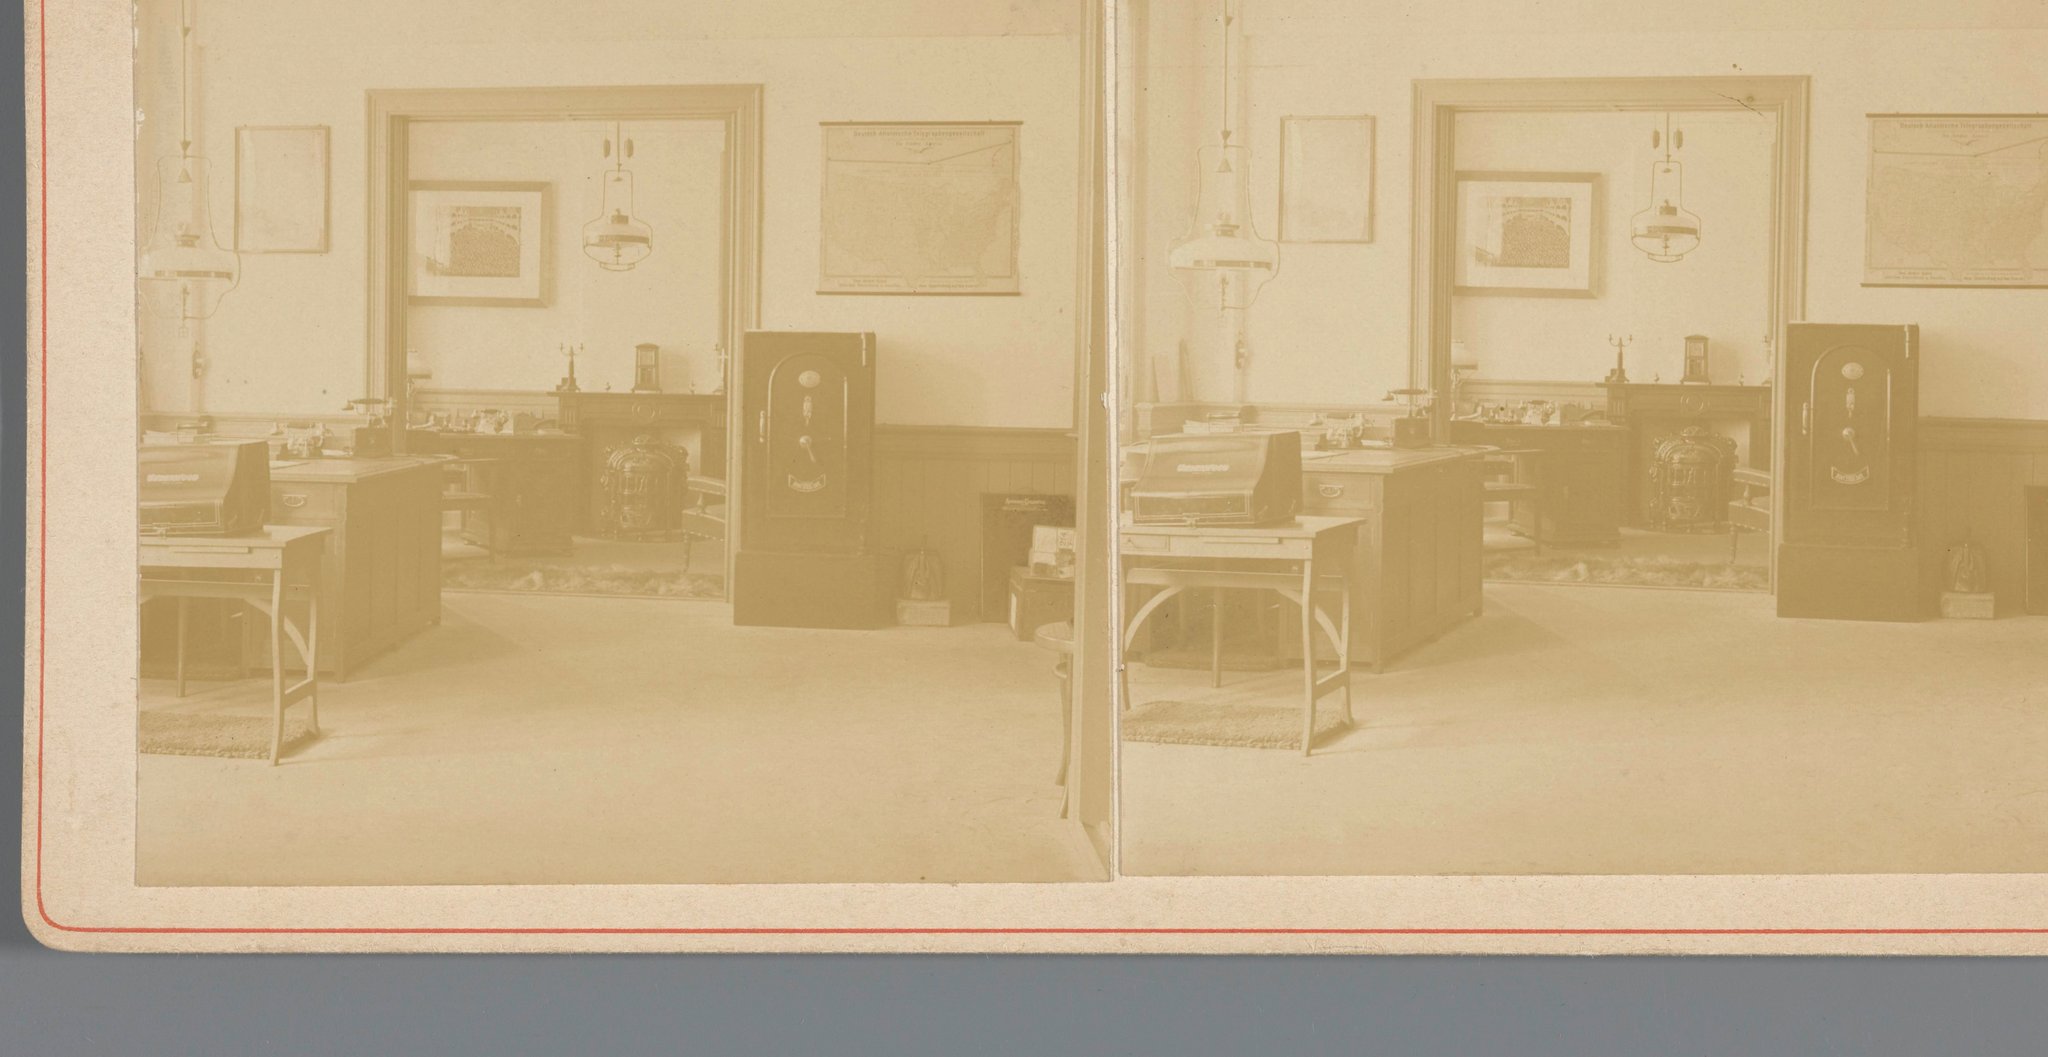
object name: stereograph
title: Interieur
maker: Anonymous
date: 1900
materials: cardboard, photographic support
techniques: gelatin silver print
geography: netherlands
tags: office (~ administration)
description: Interieur van een leeg kantoor (zie voor hetzelfde kantoor RP-F-2015-114-18). Onderdeel van een groep van 5 foto's en 19 stereofoto's gemaakt door een onbekende amateurfotograaf rond 1900 in Amsterdam, de Ardennen en Denemarken.